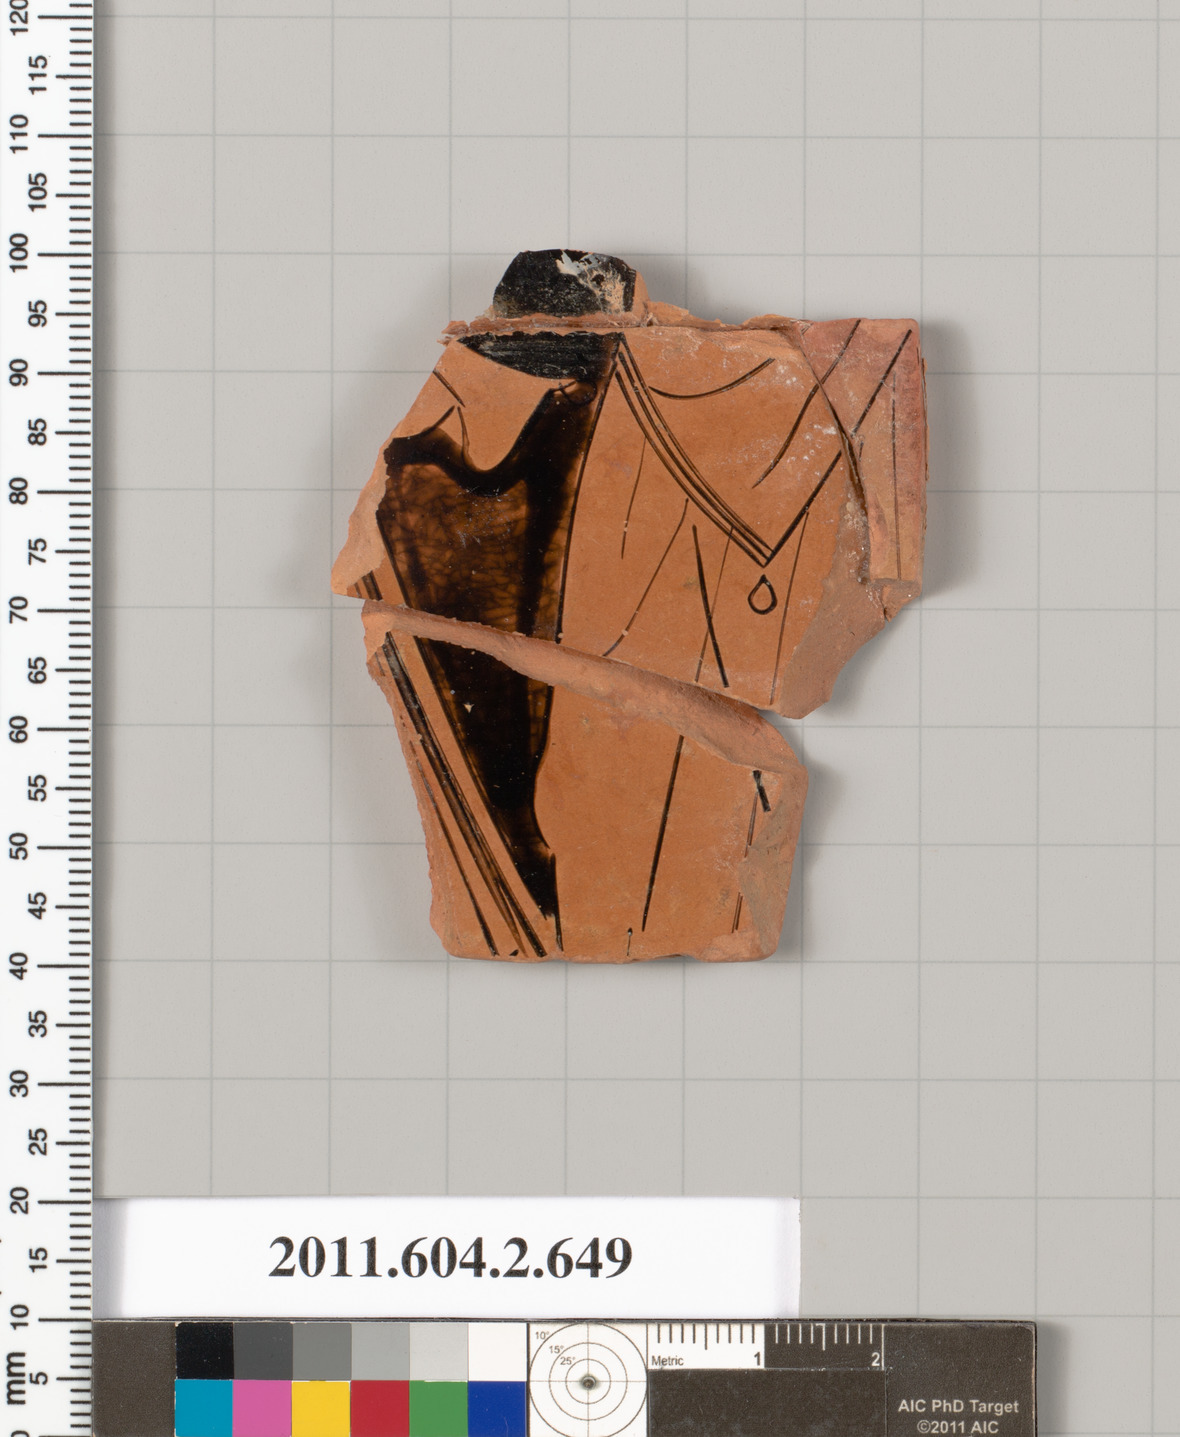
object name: column krater fragment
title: Terracotta fragment of a column-krater (bowl for mixing wine and water)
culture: greek, attic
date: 460-450 BCE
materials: terracotta